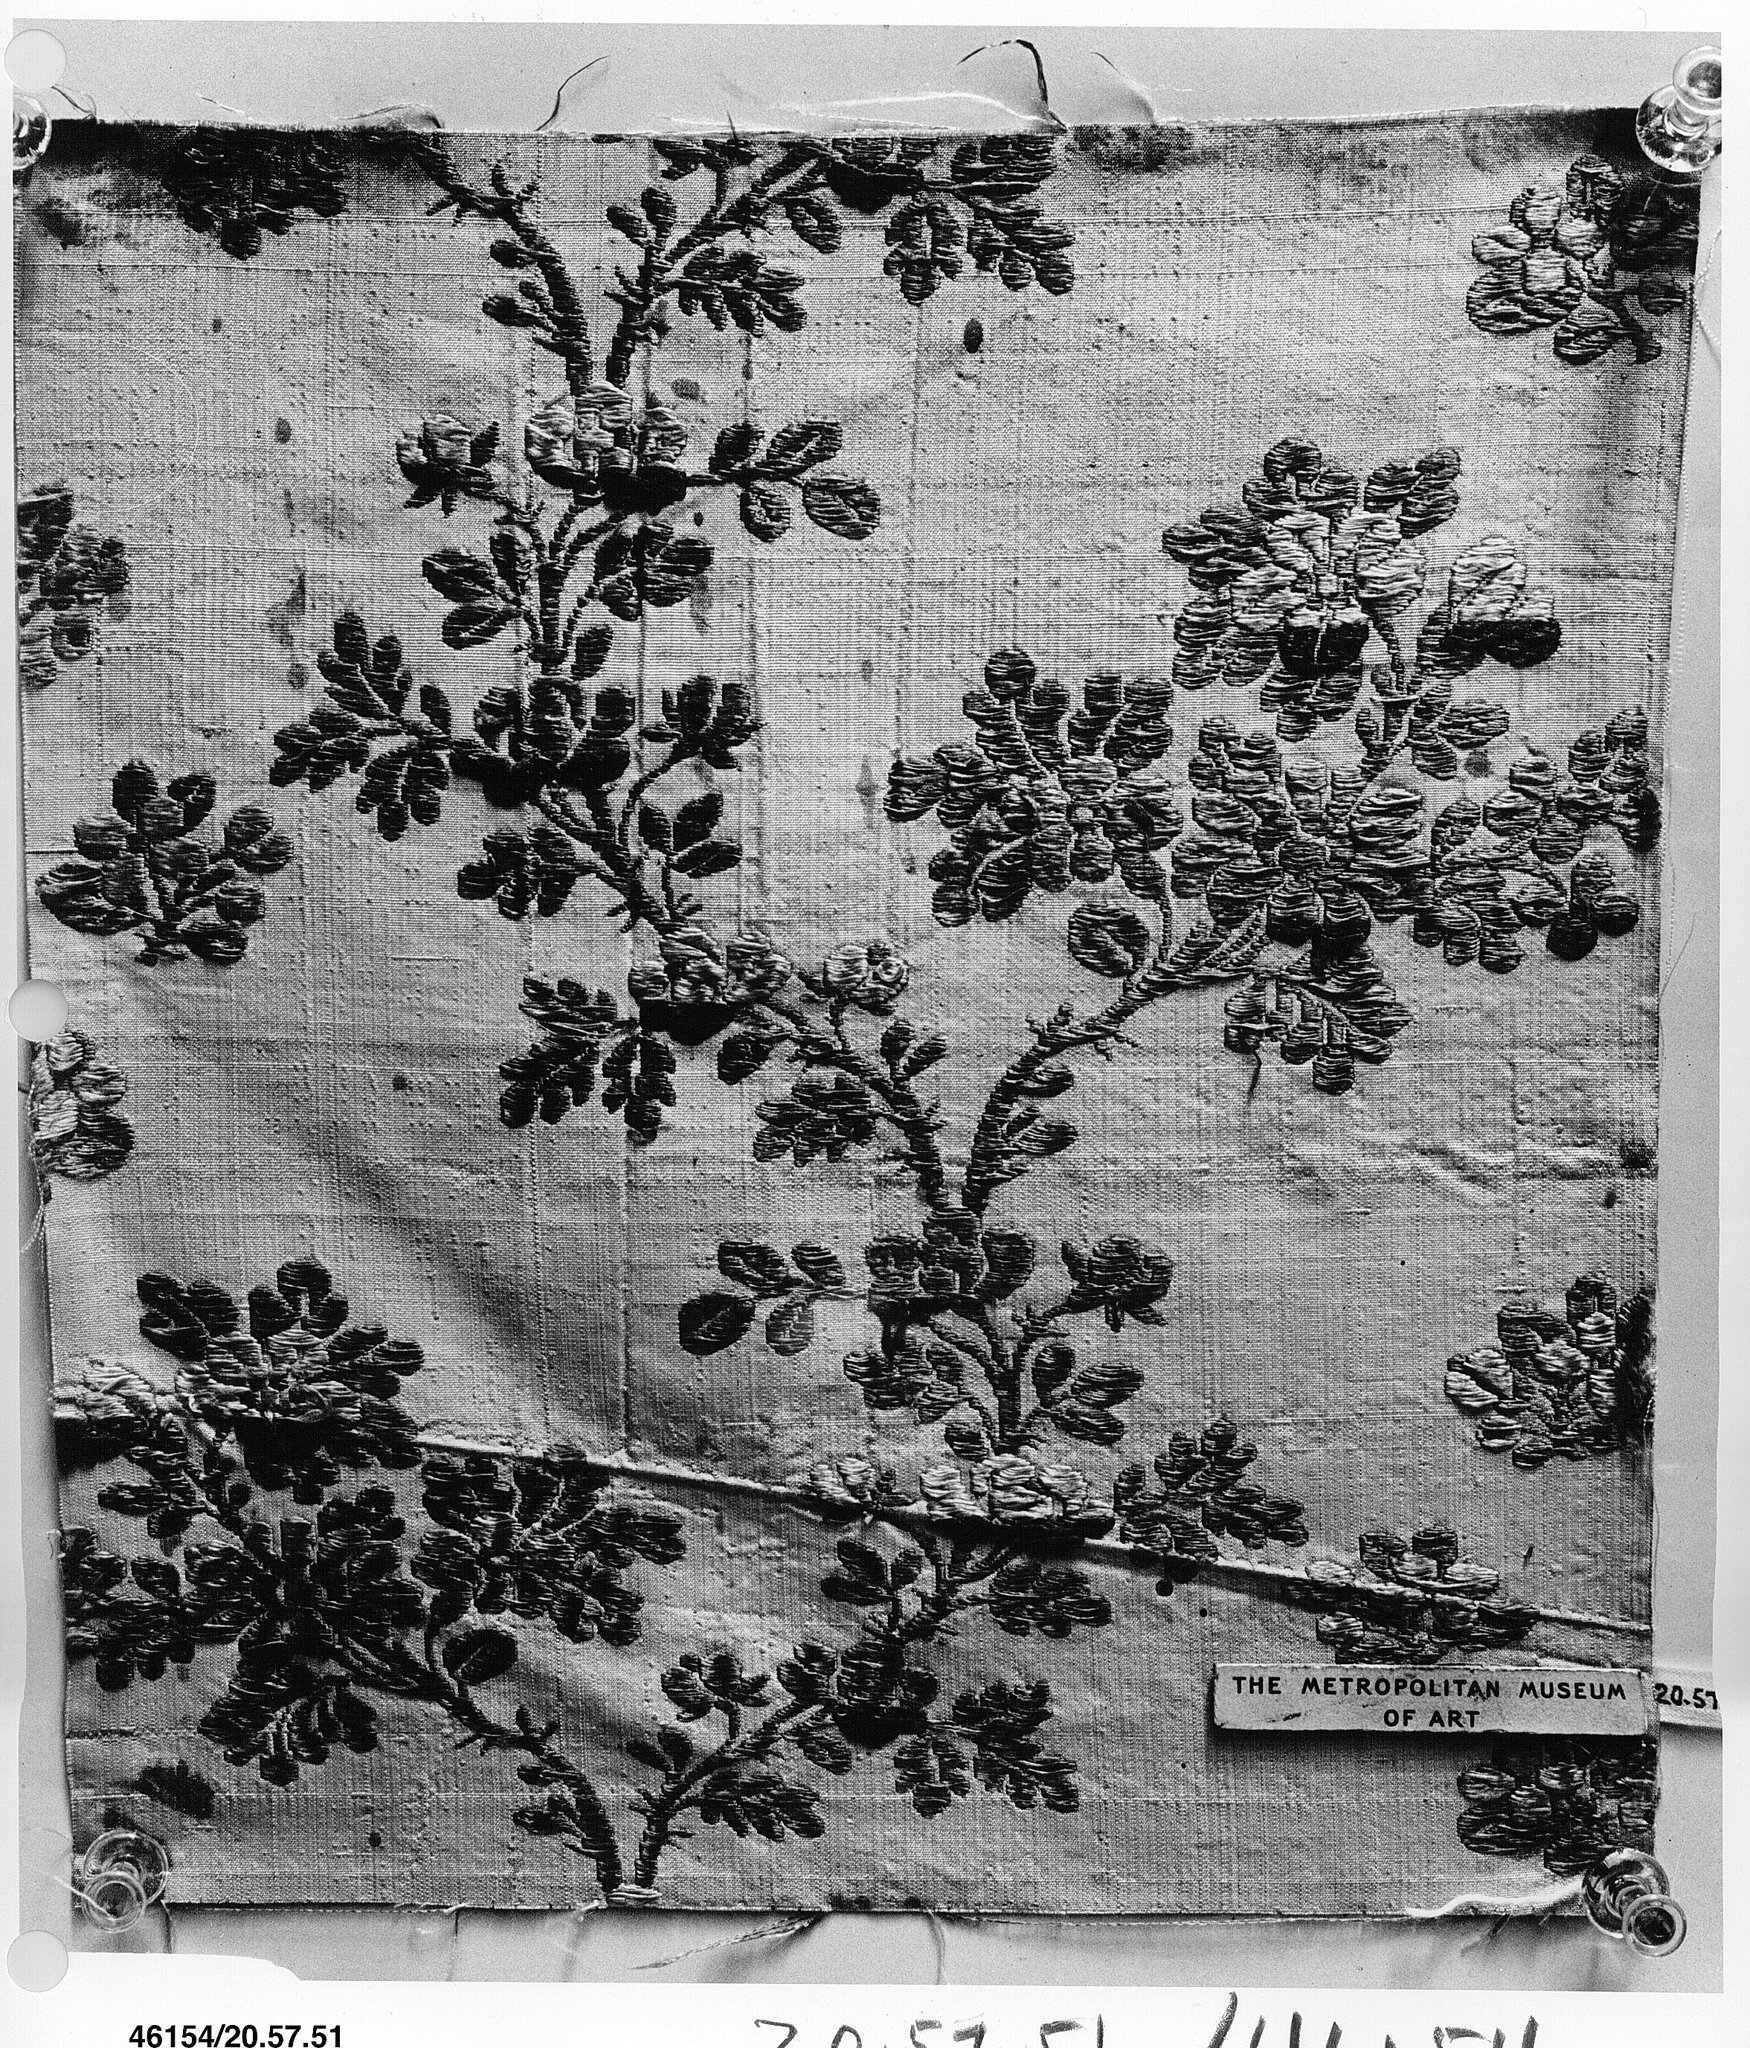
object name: piece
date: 1760-1770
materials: silk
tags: flowers,leaves